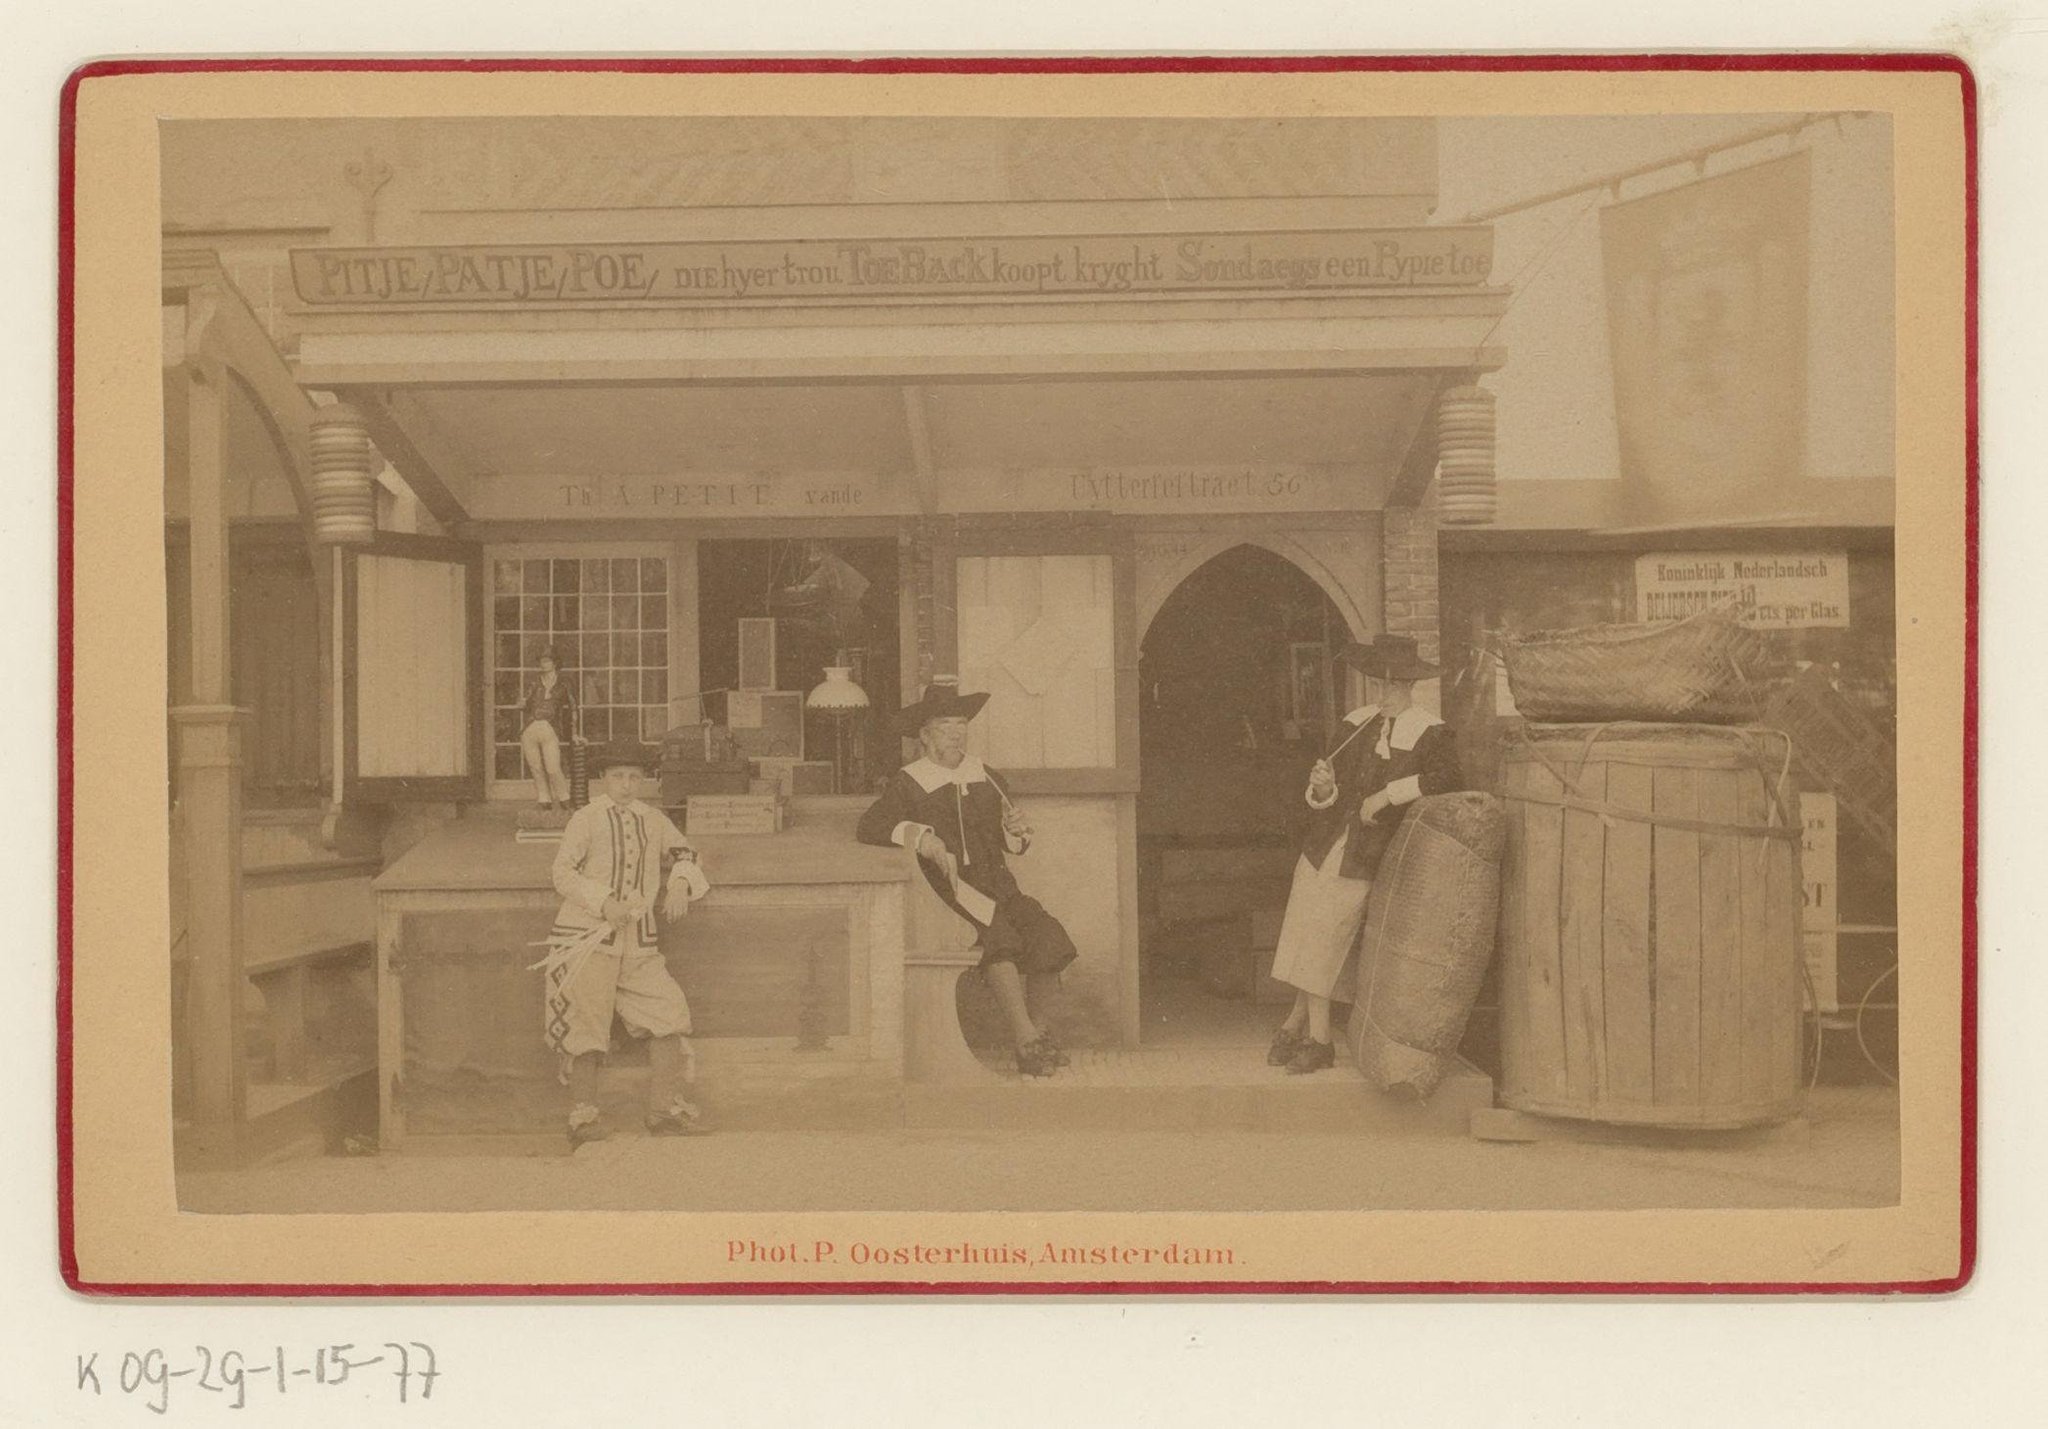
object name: photograph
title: Tabakshuisje Pitje, Patje Poe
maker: pieter oosterhuis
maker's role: draughtsman, print maker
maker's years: 1816-1885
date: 1831-1885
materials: cardboard, paper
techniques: albumen print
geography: amsterdam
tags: tobacco, shop-window, show-window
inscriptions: stamp, collector's mark: Lugt 1641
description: Onderwerpsrubrieken binnen de Atlas Zeden en Gewoonten: Handel, nijverheid en verkeer, Tentoonstellingen.